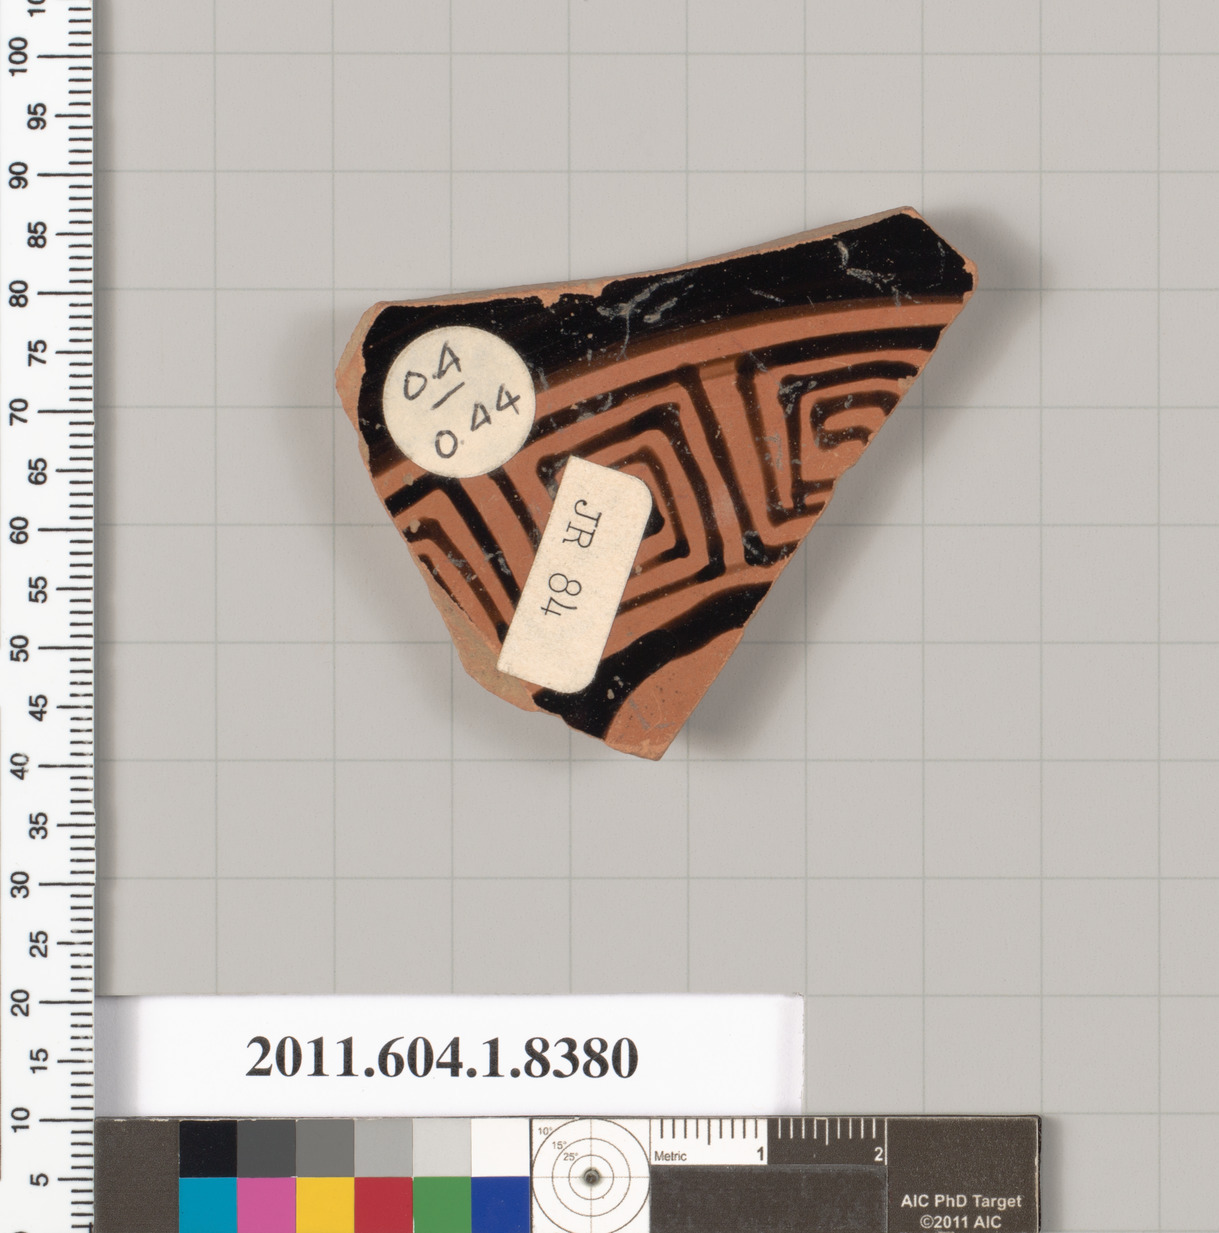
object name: kylix fragment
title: Terracotta fragment of a kylix (drinking cup)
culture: greek, attic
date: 375-351 BCE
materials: terracotta